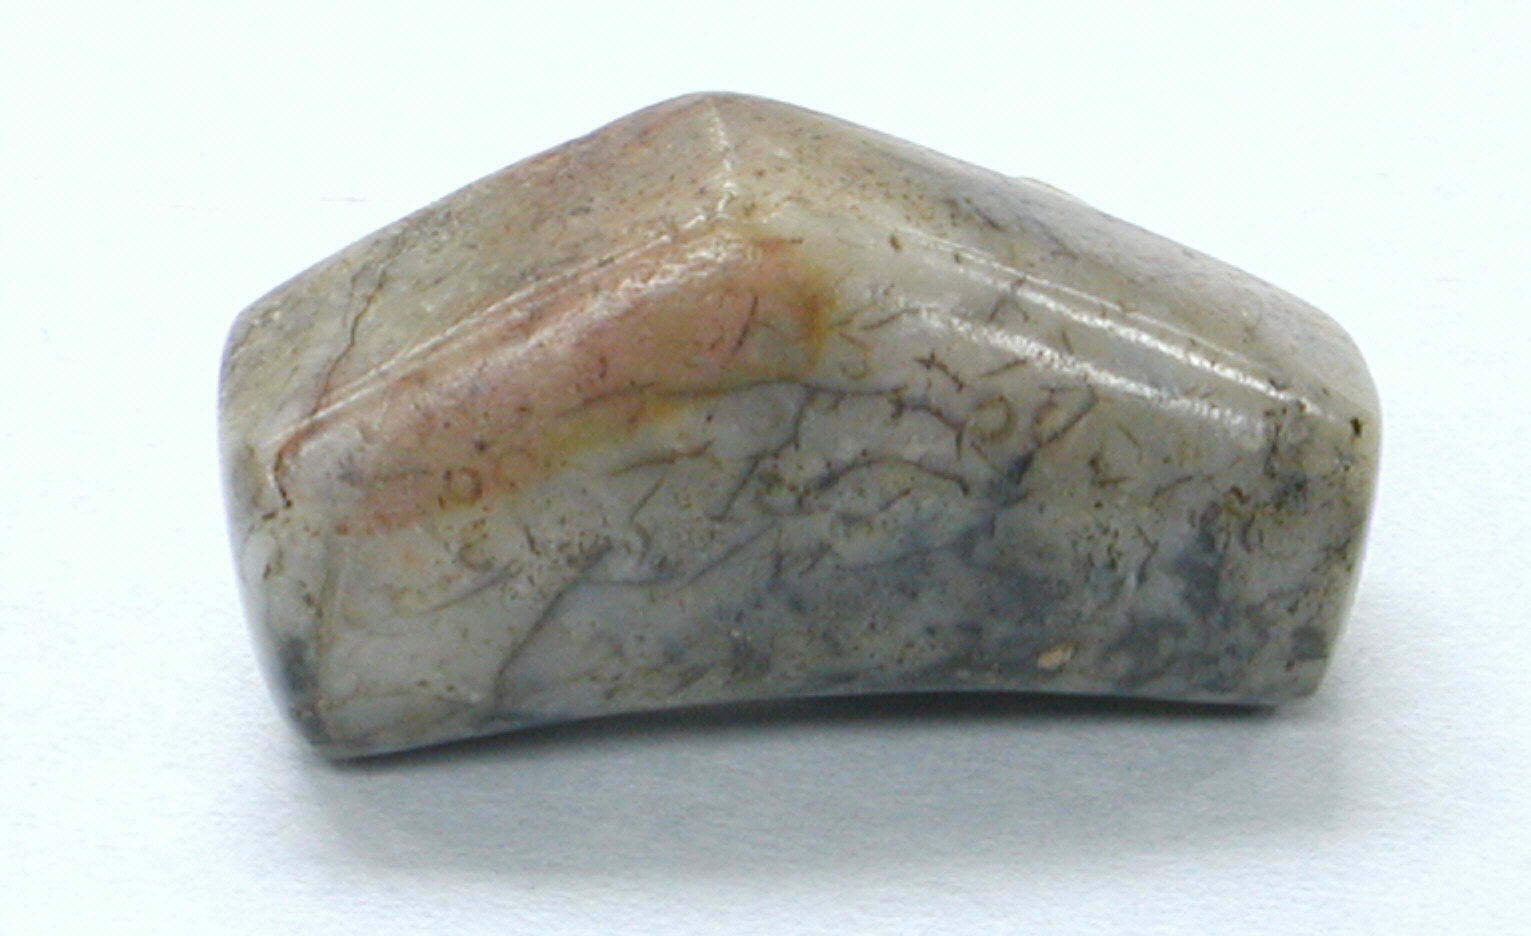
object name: ritual stone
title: Stone Pulidor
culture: mexican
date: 1501-1600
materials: stone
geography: mexico